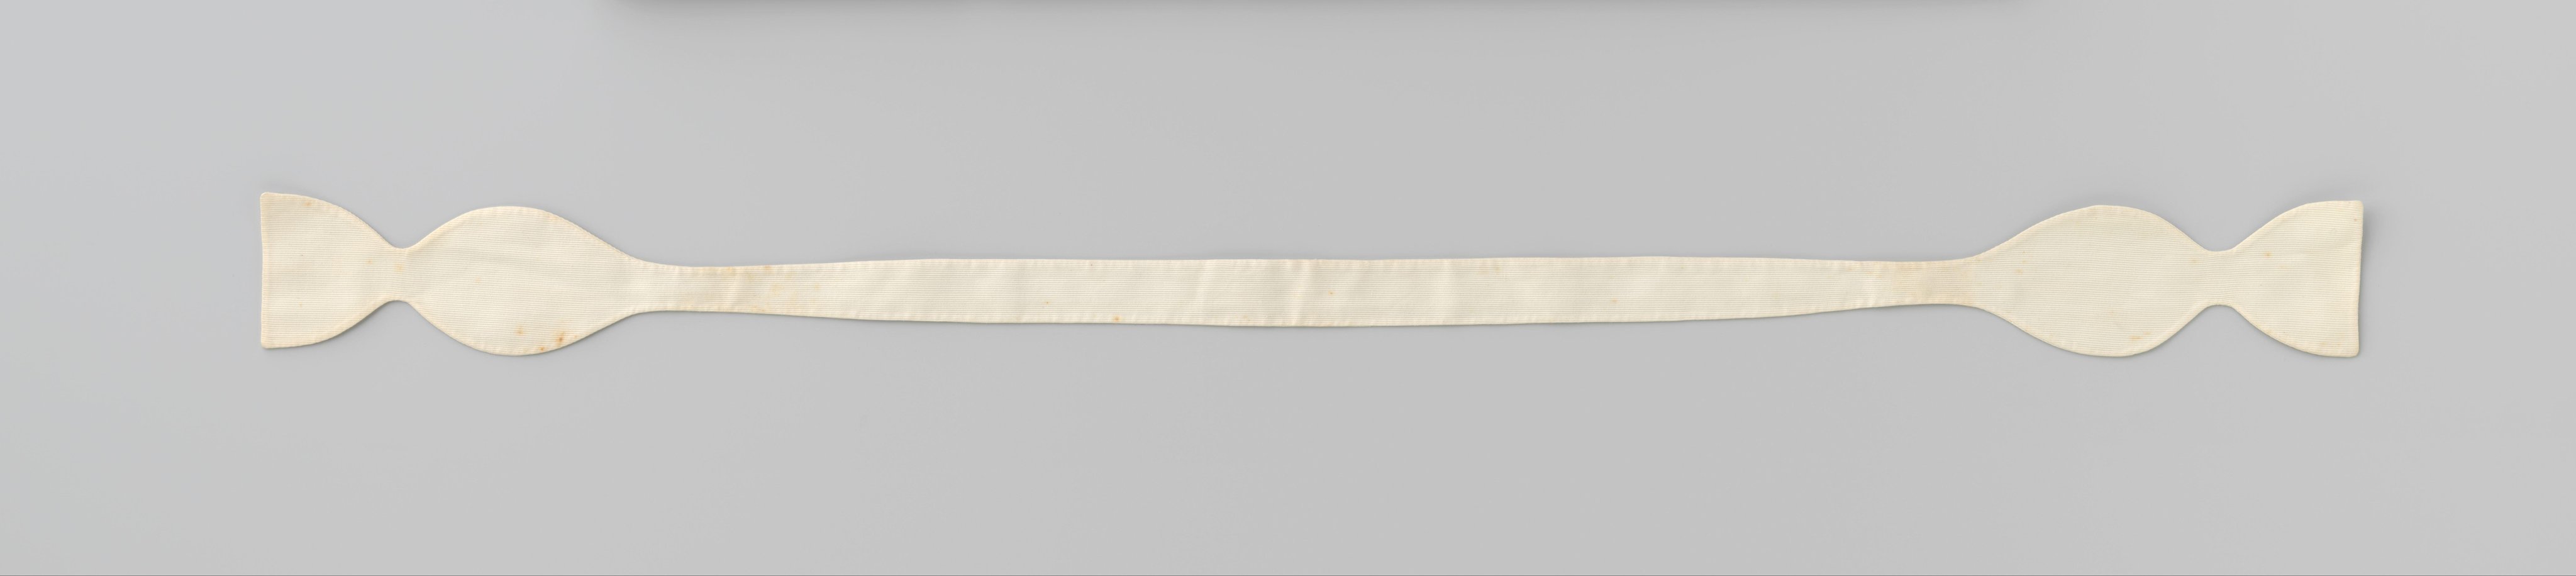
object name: menswear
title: Witte strik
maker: Anonymous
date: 1920-1980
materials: textile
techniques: weave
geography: europe